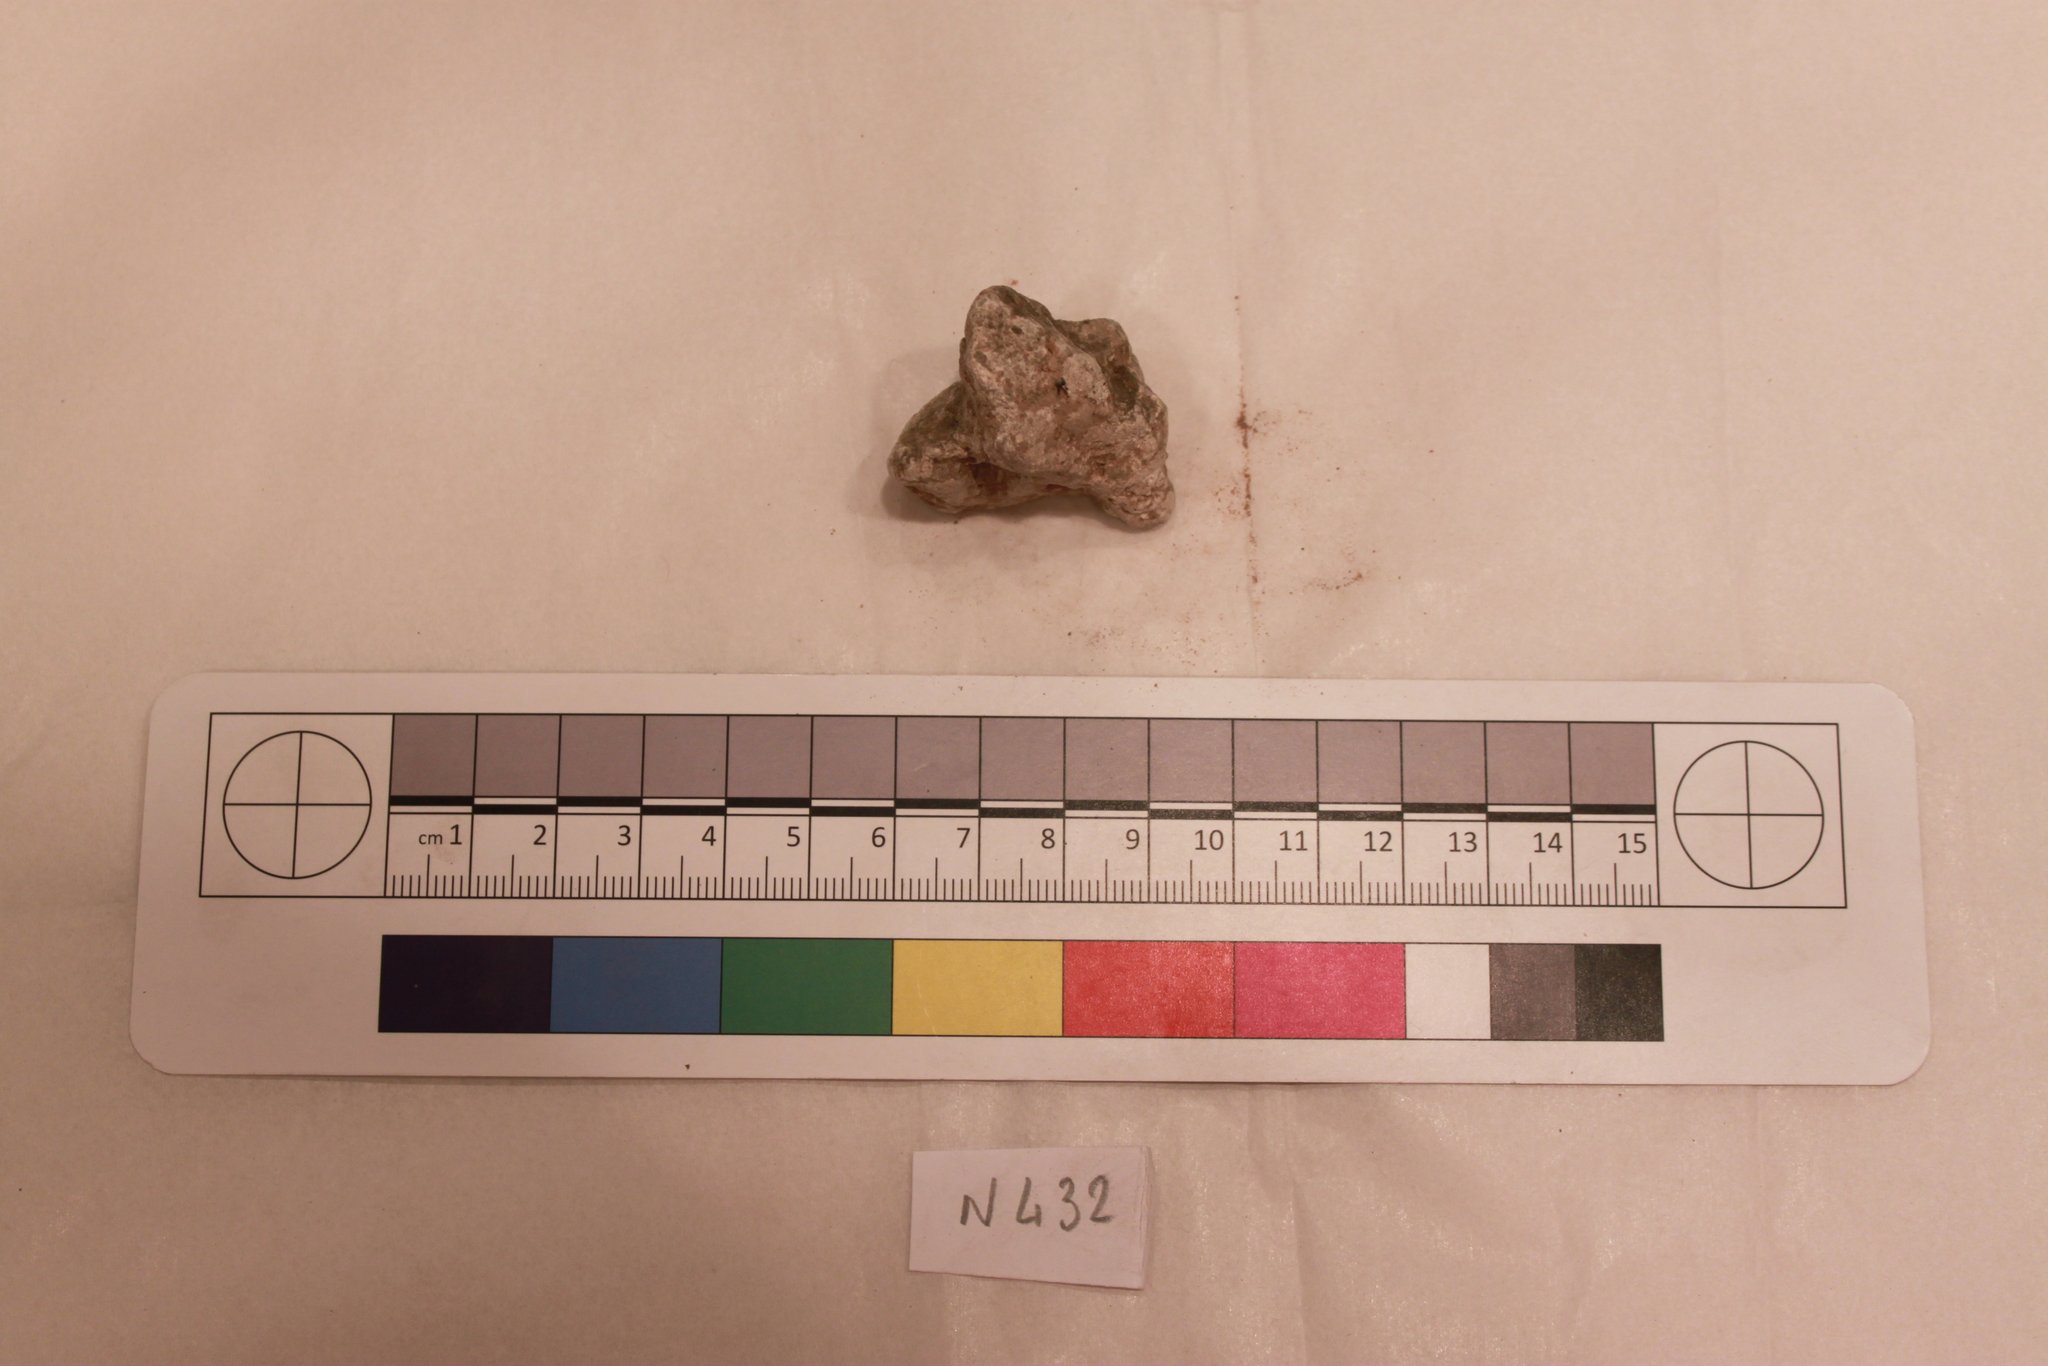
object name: fragment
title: Stucco Fragment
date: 701-1200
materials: plaster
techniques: carving, painting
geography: iran